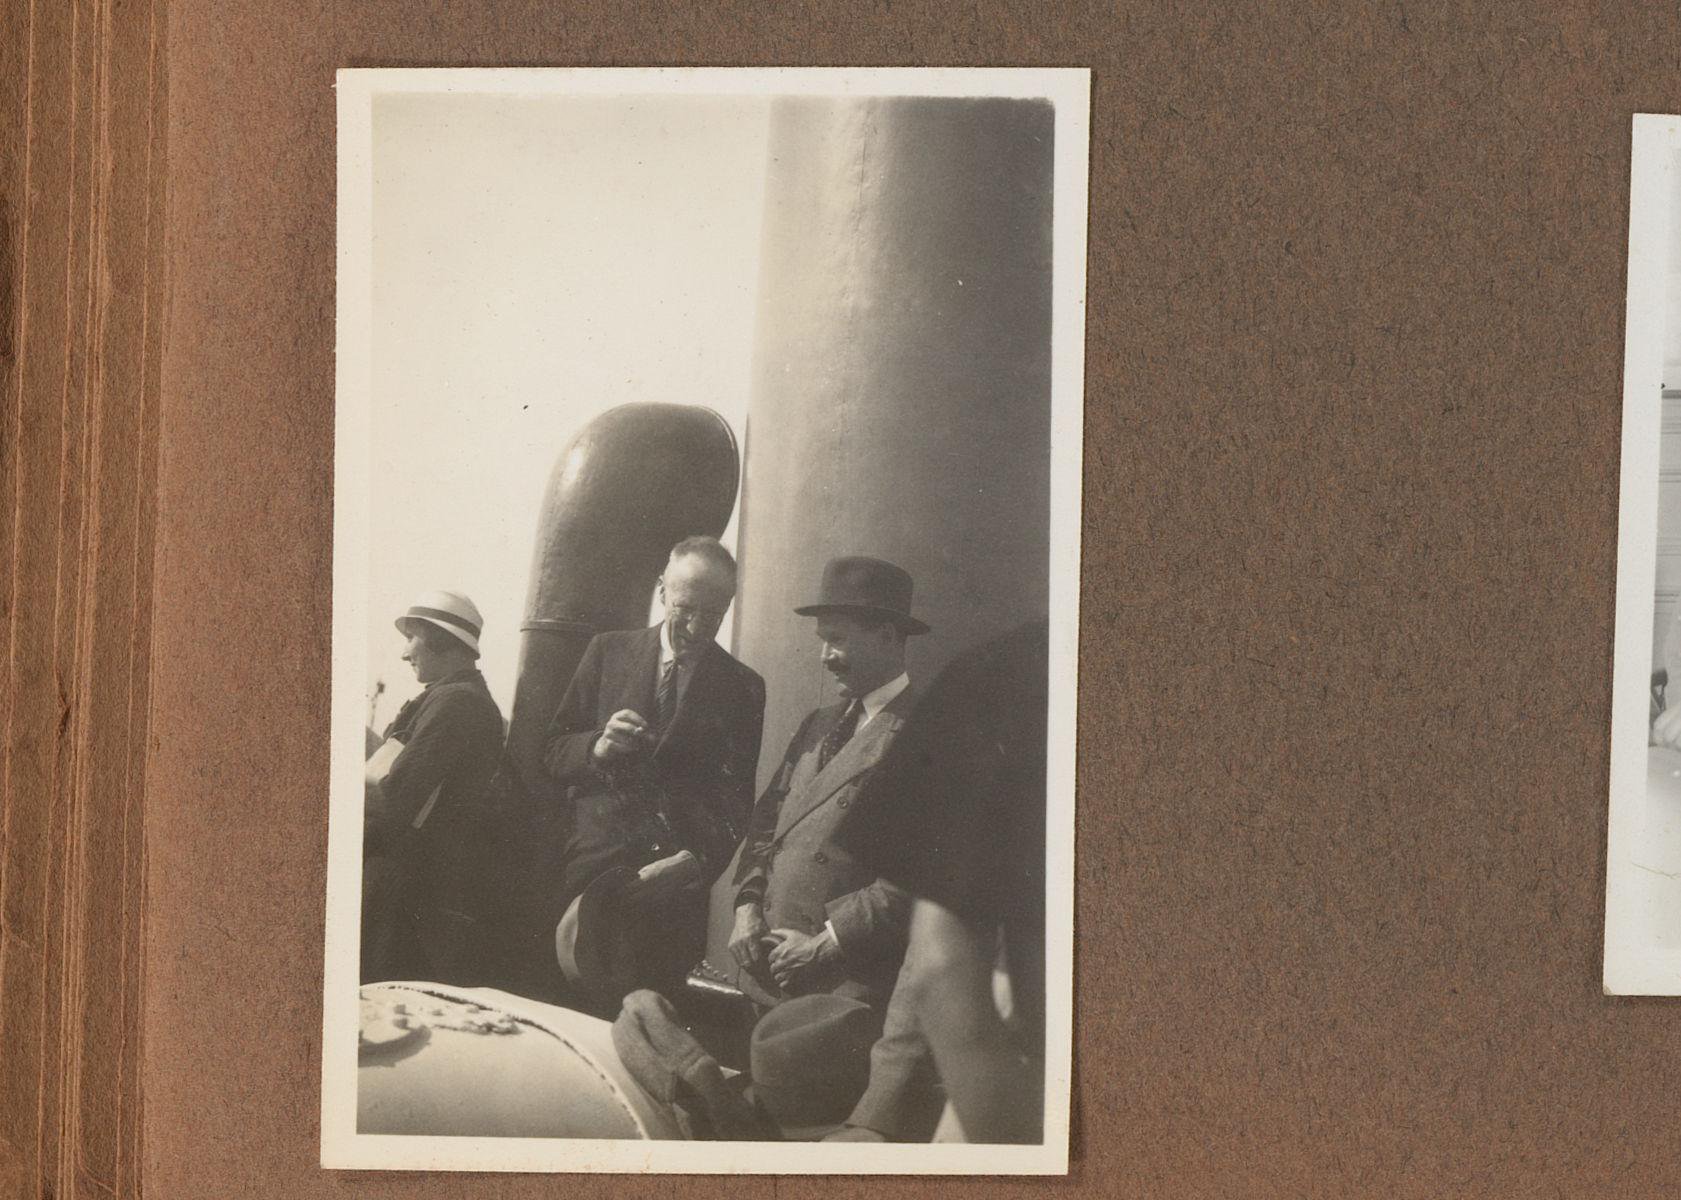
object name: photograph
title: Gezelschap (op schip?)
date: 1900-1920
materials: photographic support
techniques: photography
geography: amsterdam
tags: netherlands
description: Foto op bruin albumblad 54 van familiealbum van Alphons Diepenbrock.